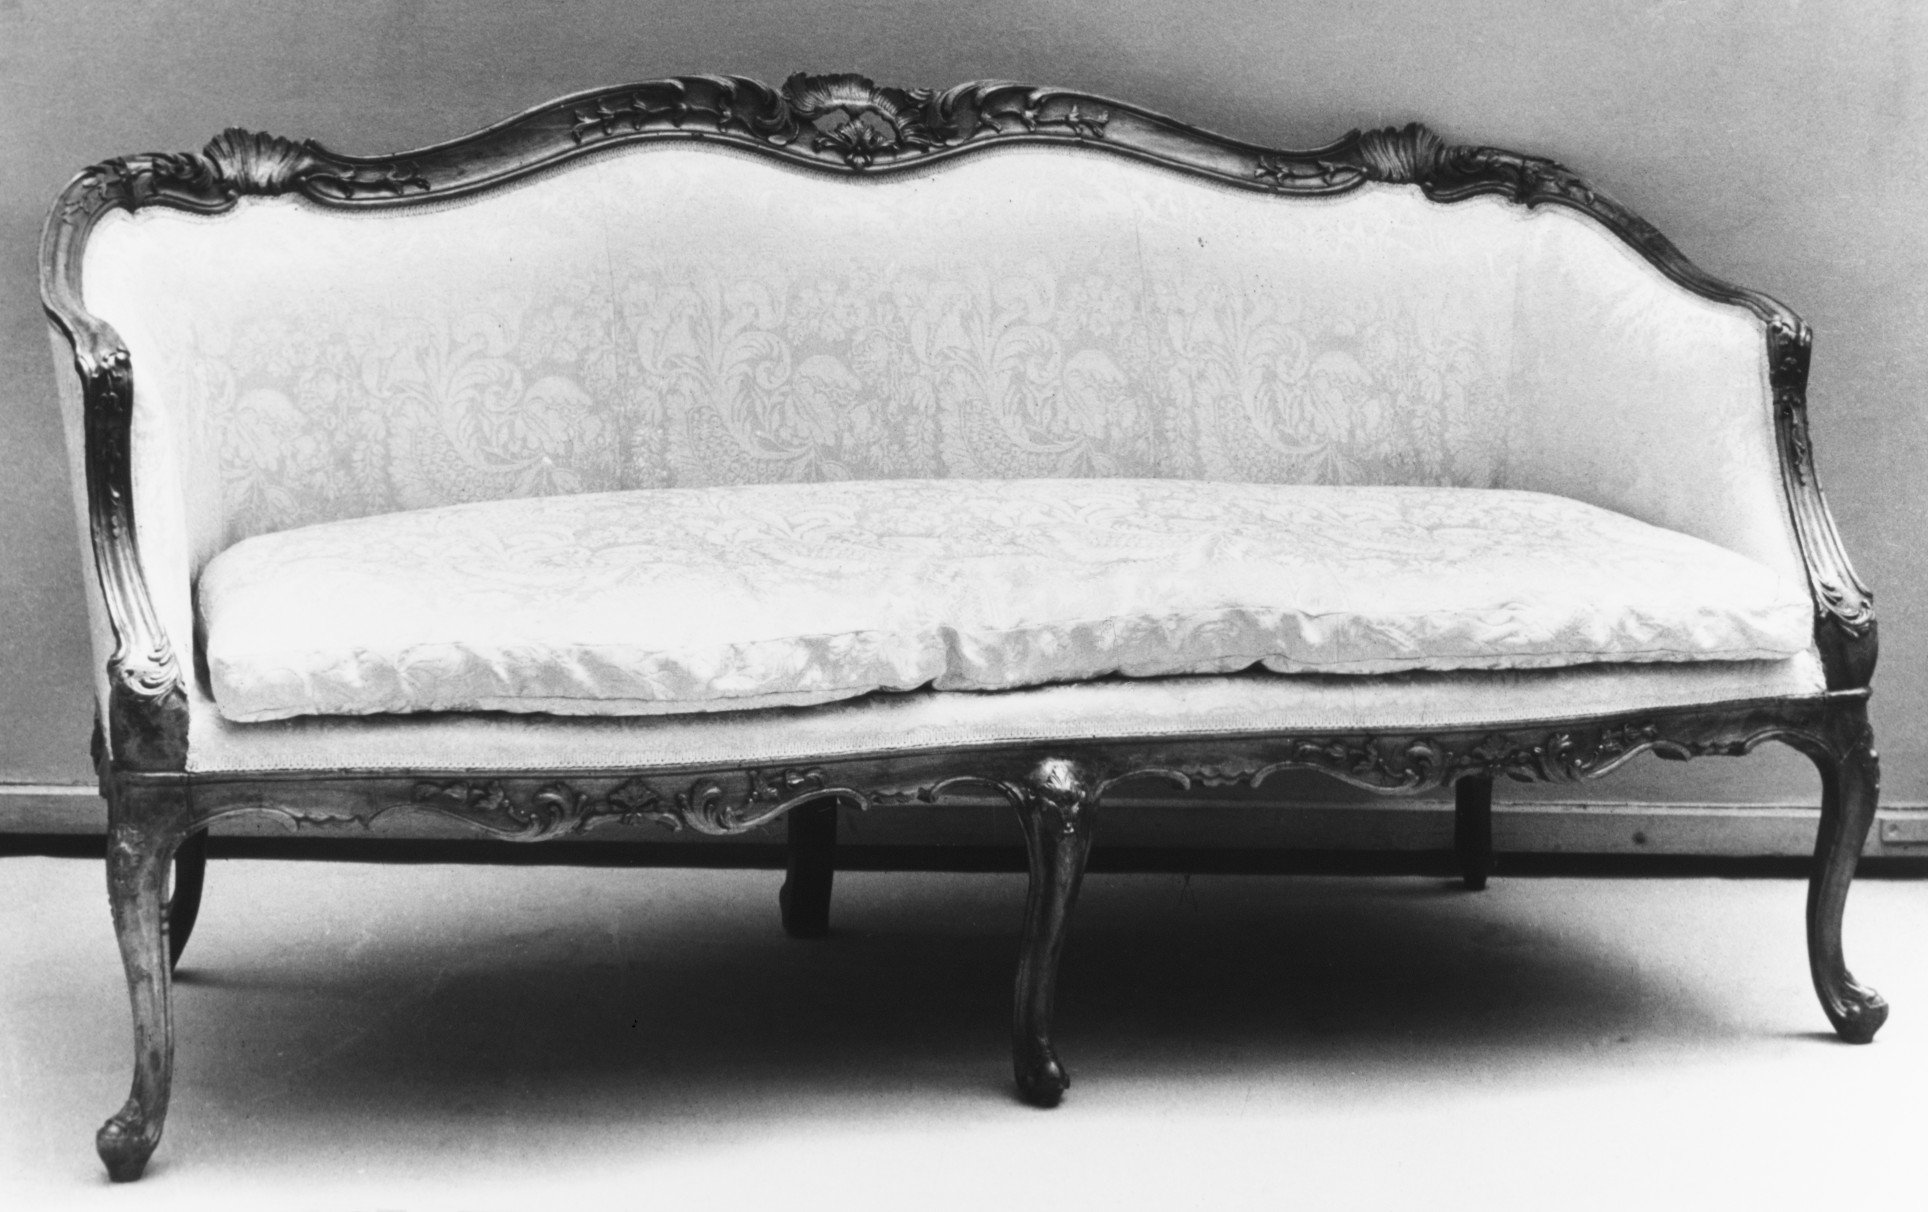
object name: settee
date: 1734-1766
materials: wood